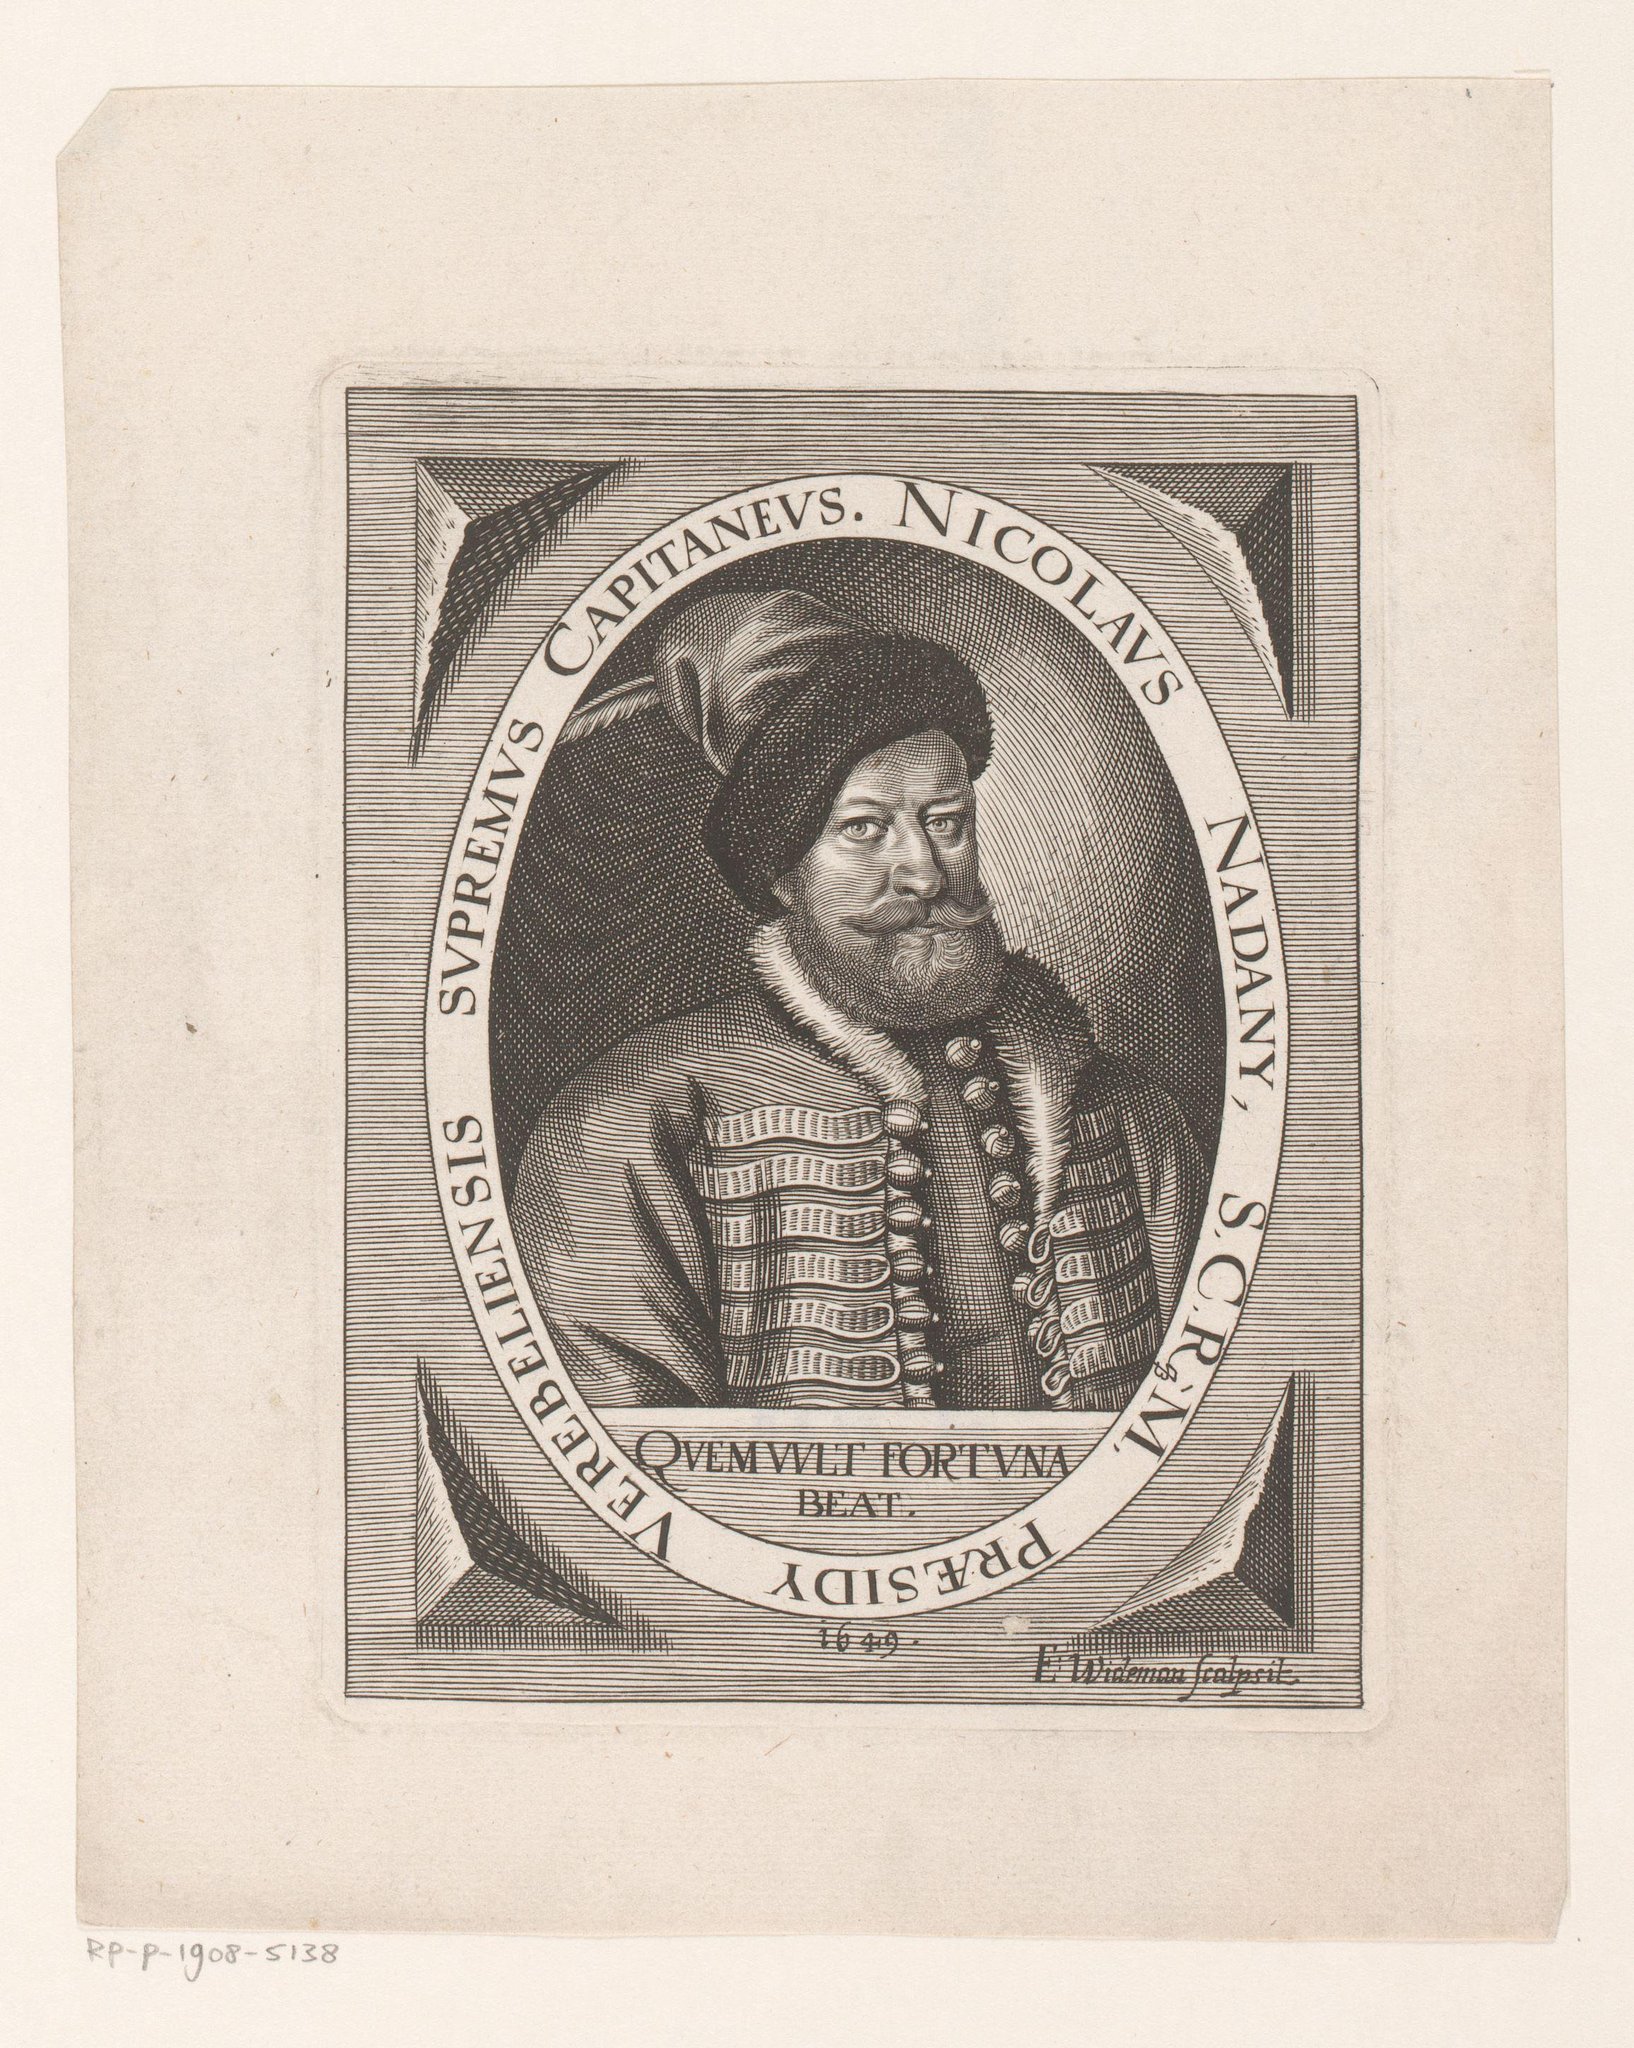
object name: print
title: Portret van Nicholas Nadányi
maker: elias widemann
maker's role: print maker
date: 1649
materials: paper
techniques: engraving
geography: vienna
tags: historical persons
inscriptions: collector's mark: Lugt 2228